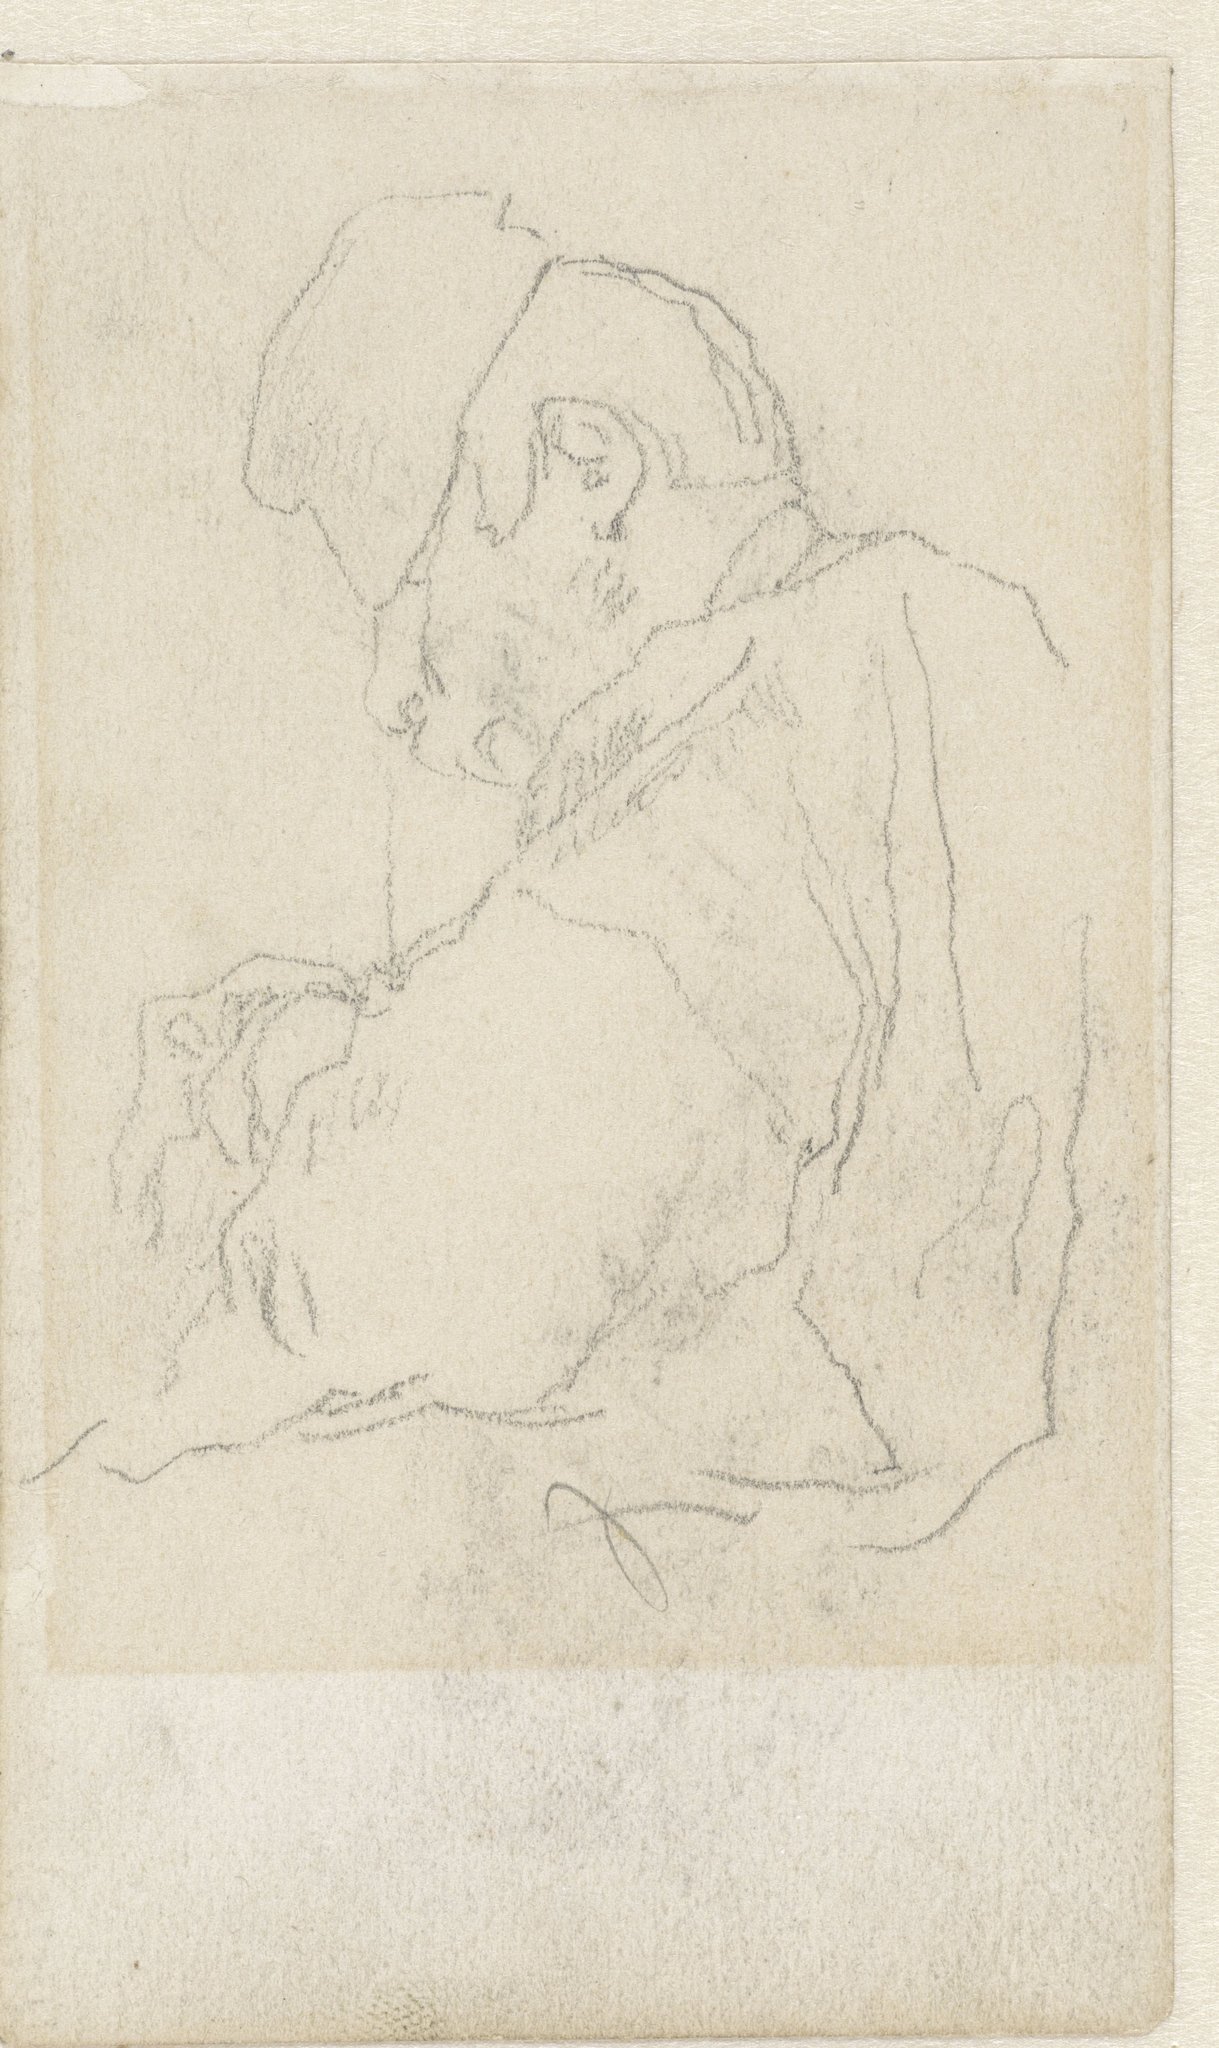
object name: drawing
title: Slapende man, van achteren gezien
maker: jacob maris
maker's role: draughtsman, painter, print maker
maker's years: 1837-1899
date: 1847-1899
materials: paper, pencil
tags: sleeping; unconsciousness